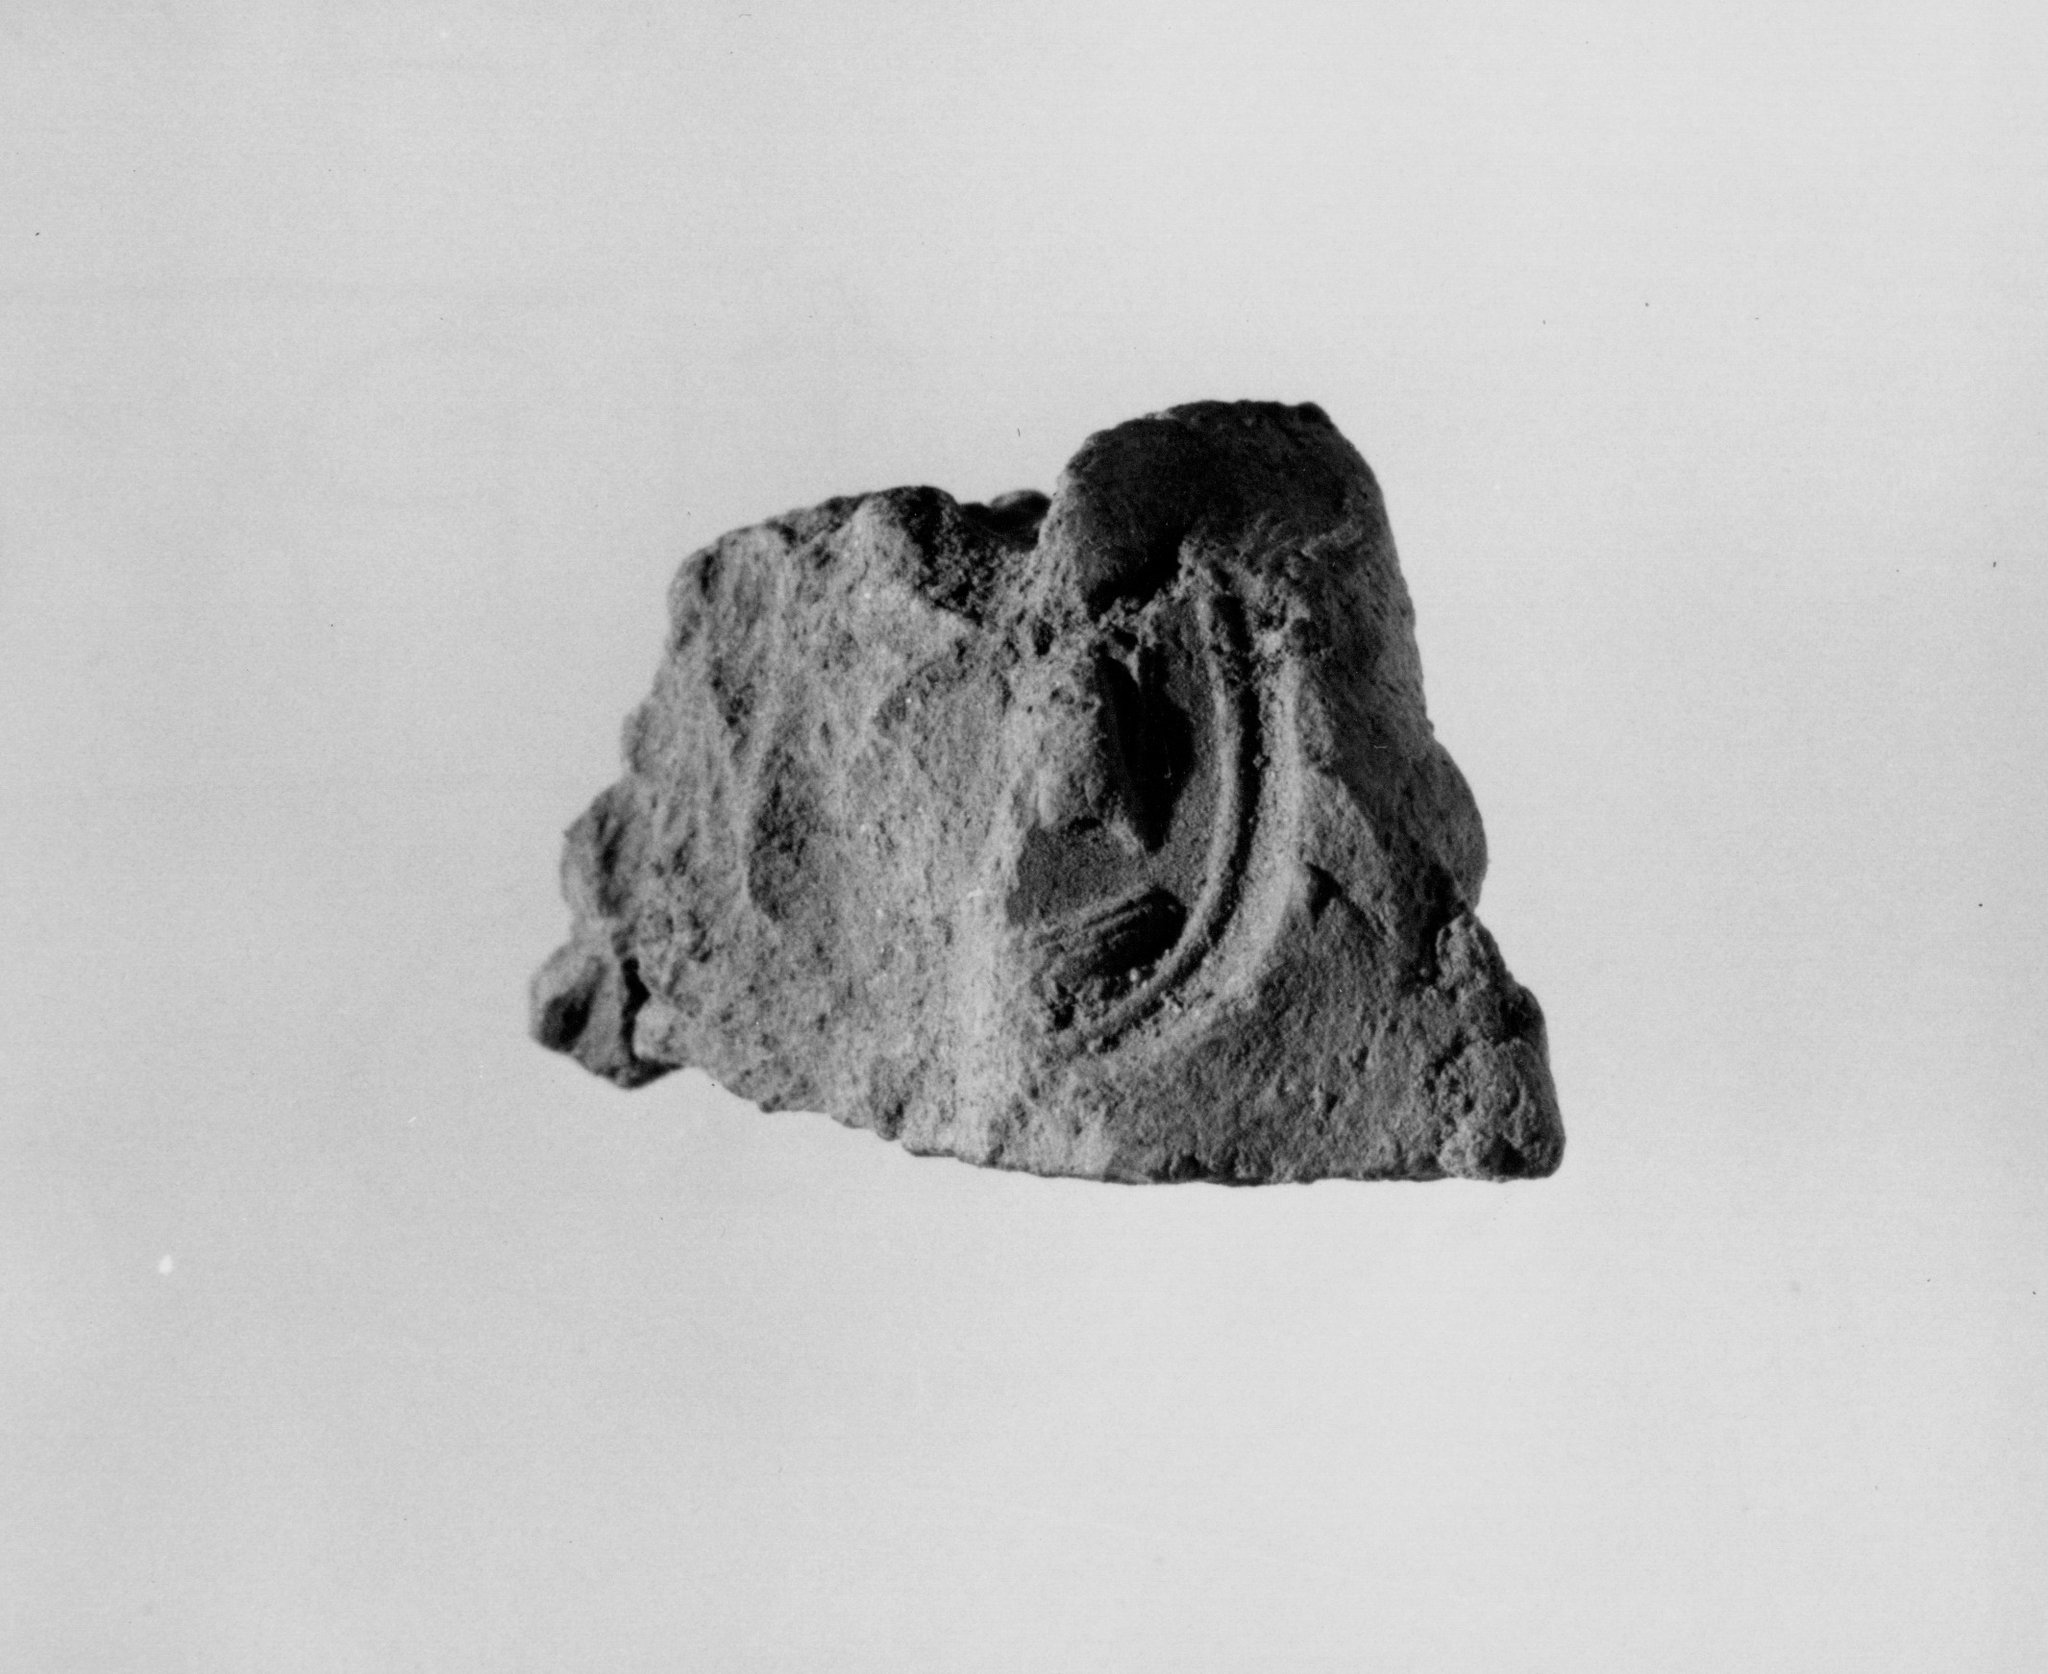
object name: sealing, nebmaatre, amenhotep iii, heb sed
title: Document Sealing With the Throne Name of Amenhotep III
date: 1390-1352 BCE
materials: mud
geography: egypt